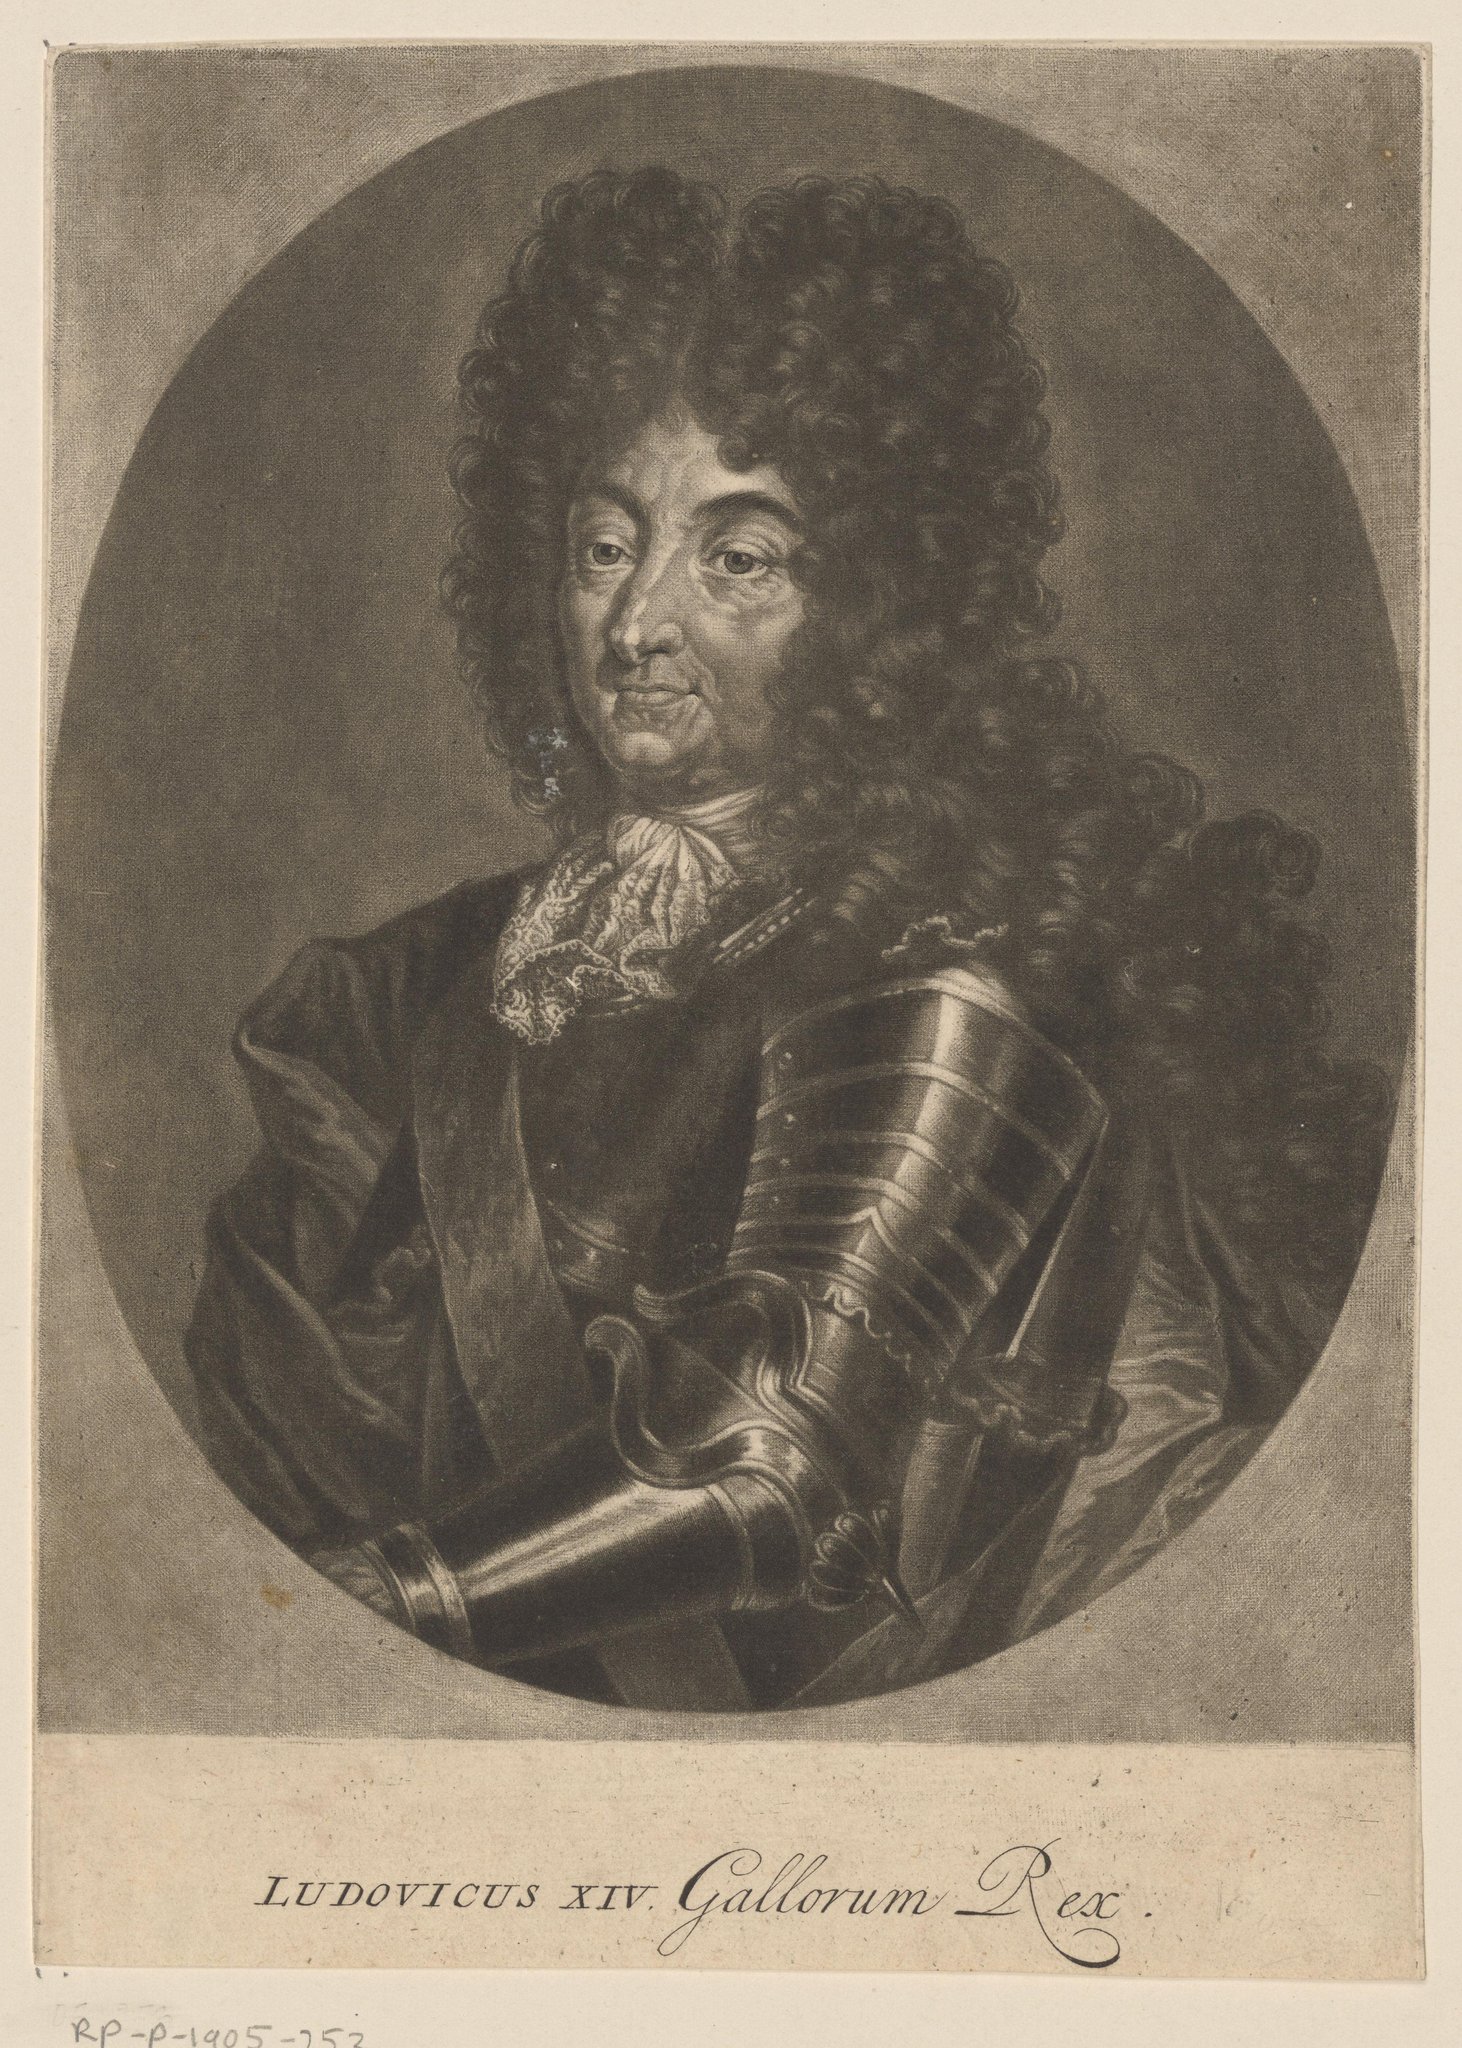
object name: print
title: Portret van Lodewijk XIV van Frankrijk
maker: pieter schenk (i)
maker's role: print maker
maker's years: 1660-1711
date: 1695-1711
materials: paper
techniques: engraving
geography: amsterdam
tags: lodewijk xiv (koning van frankrijk), armour, historical persons, king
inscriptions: collector's mark: Lugt 1337, collector's mark: Lugt 2228